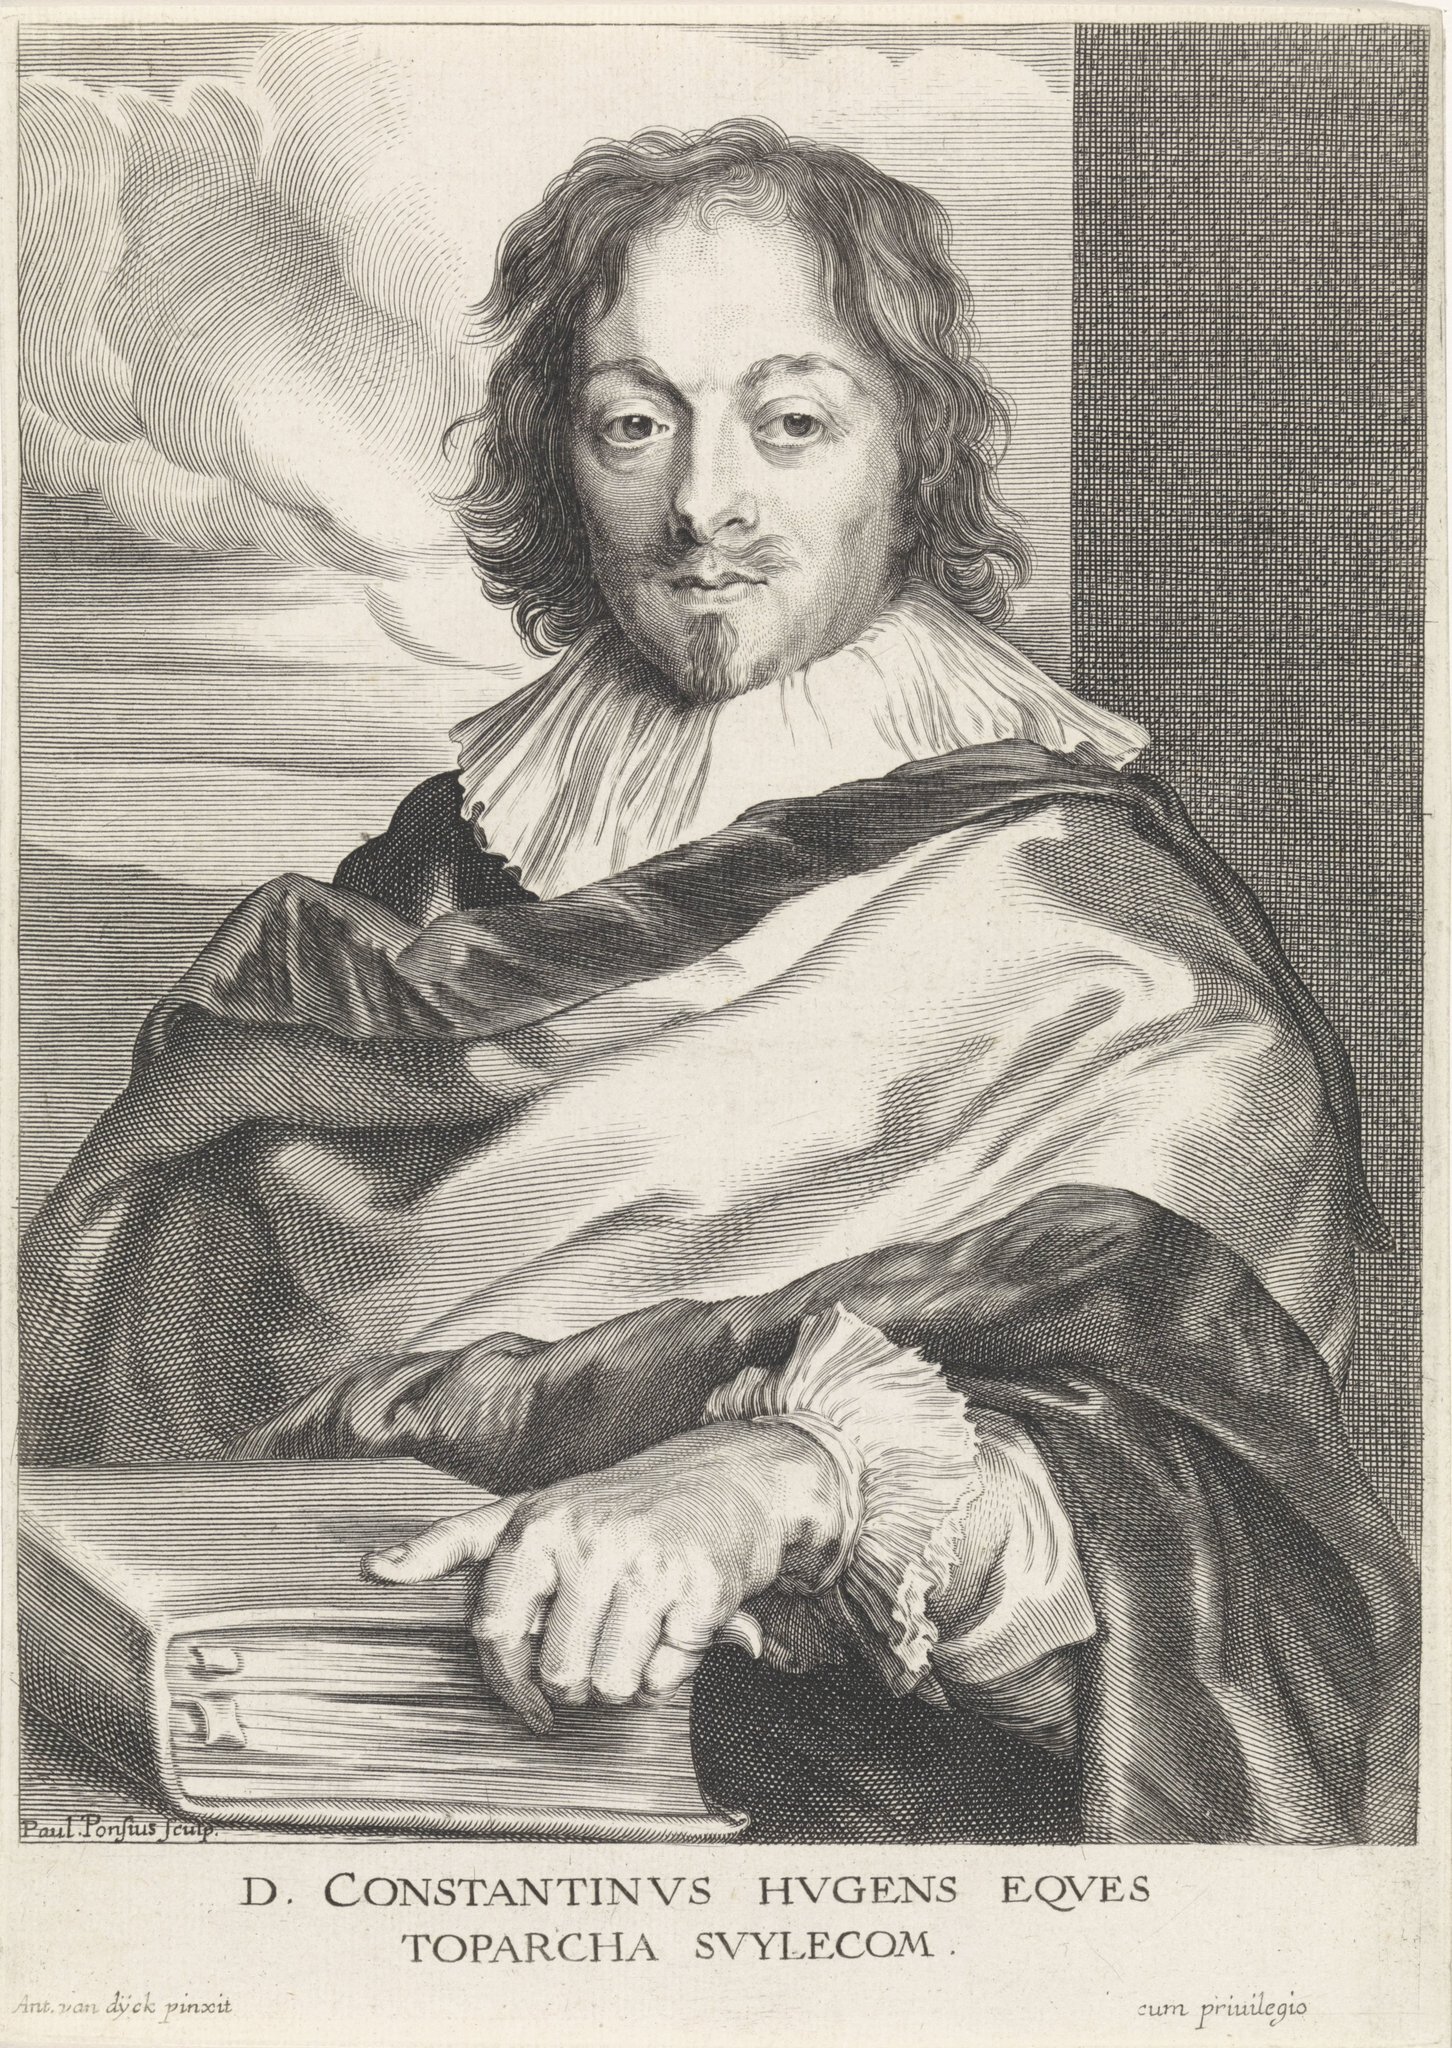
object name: print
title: Portret van Constantijn Huygens (I)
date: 1616-1657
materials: paper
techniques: engraving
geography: antwerp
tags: the hague, constantijn huygens (i), book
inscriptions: collector's mark: Lugt 2228, collector's mark: Lugt 240